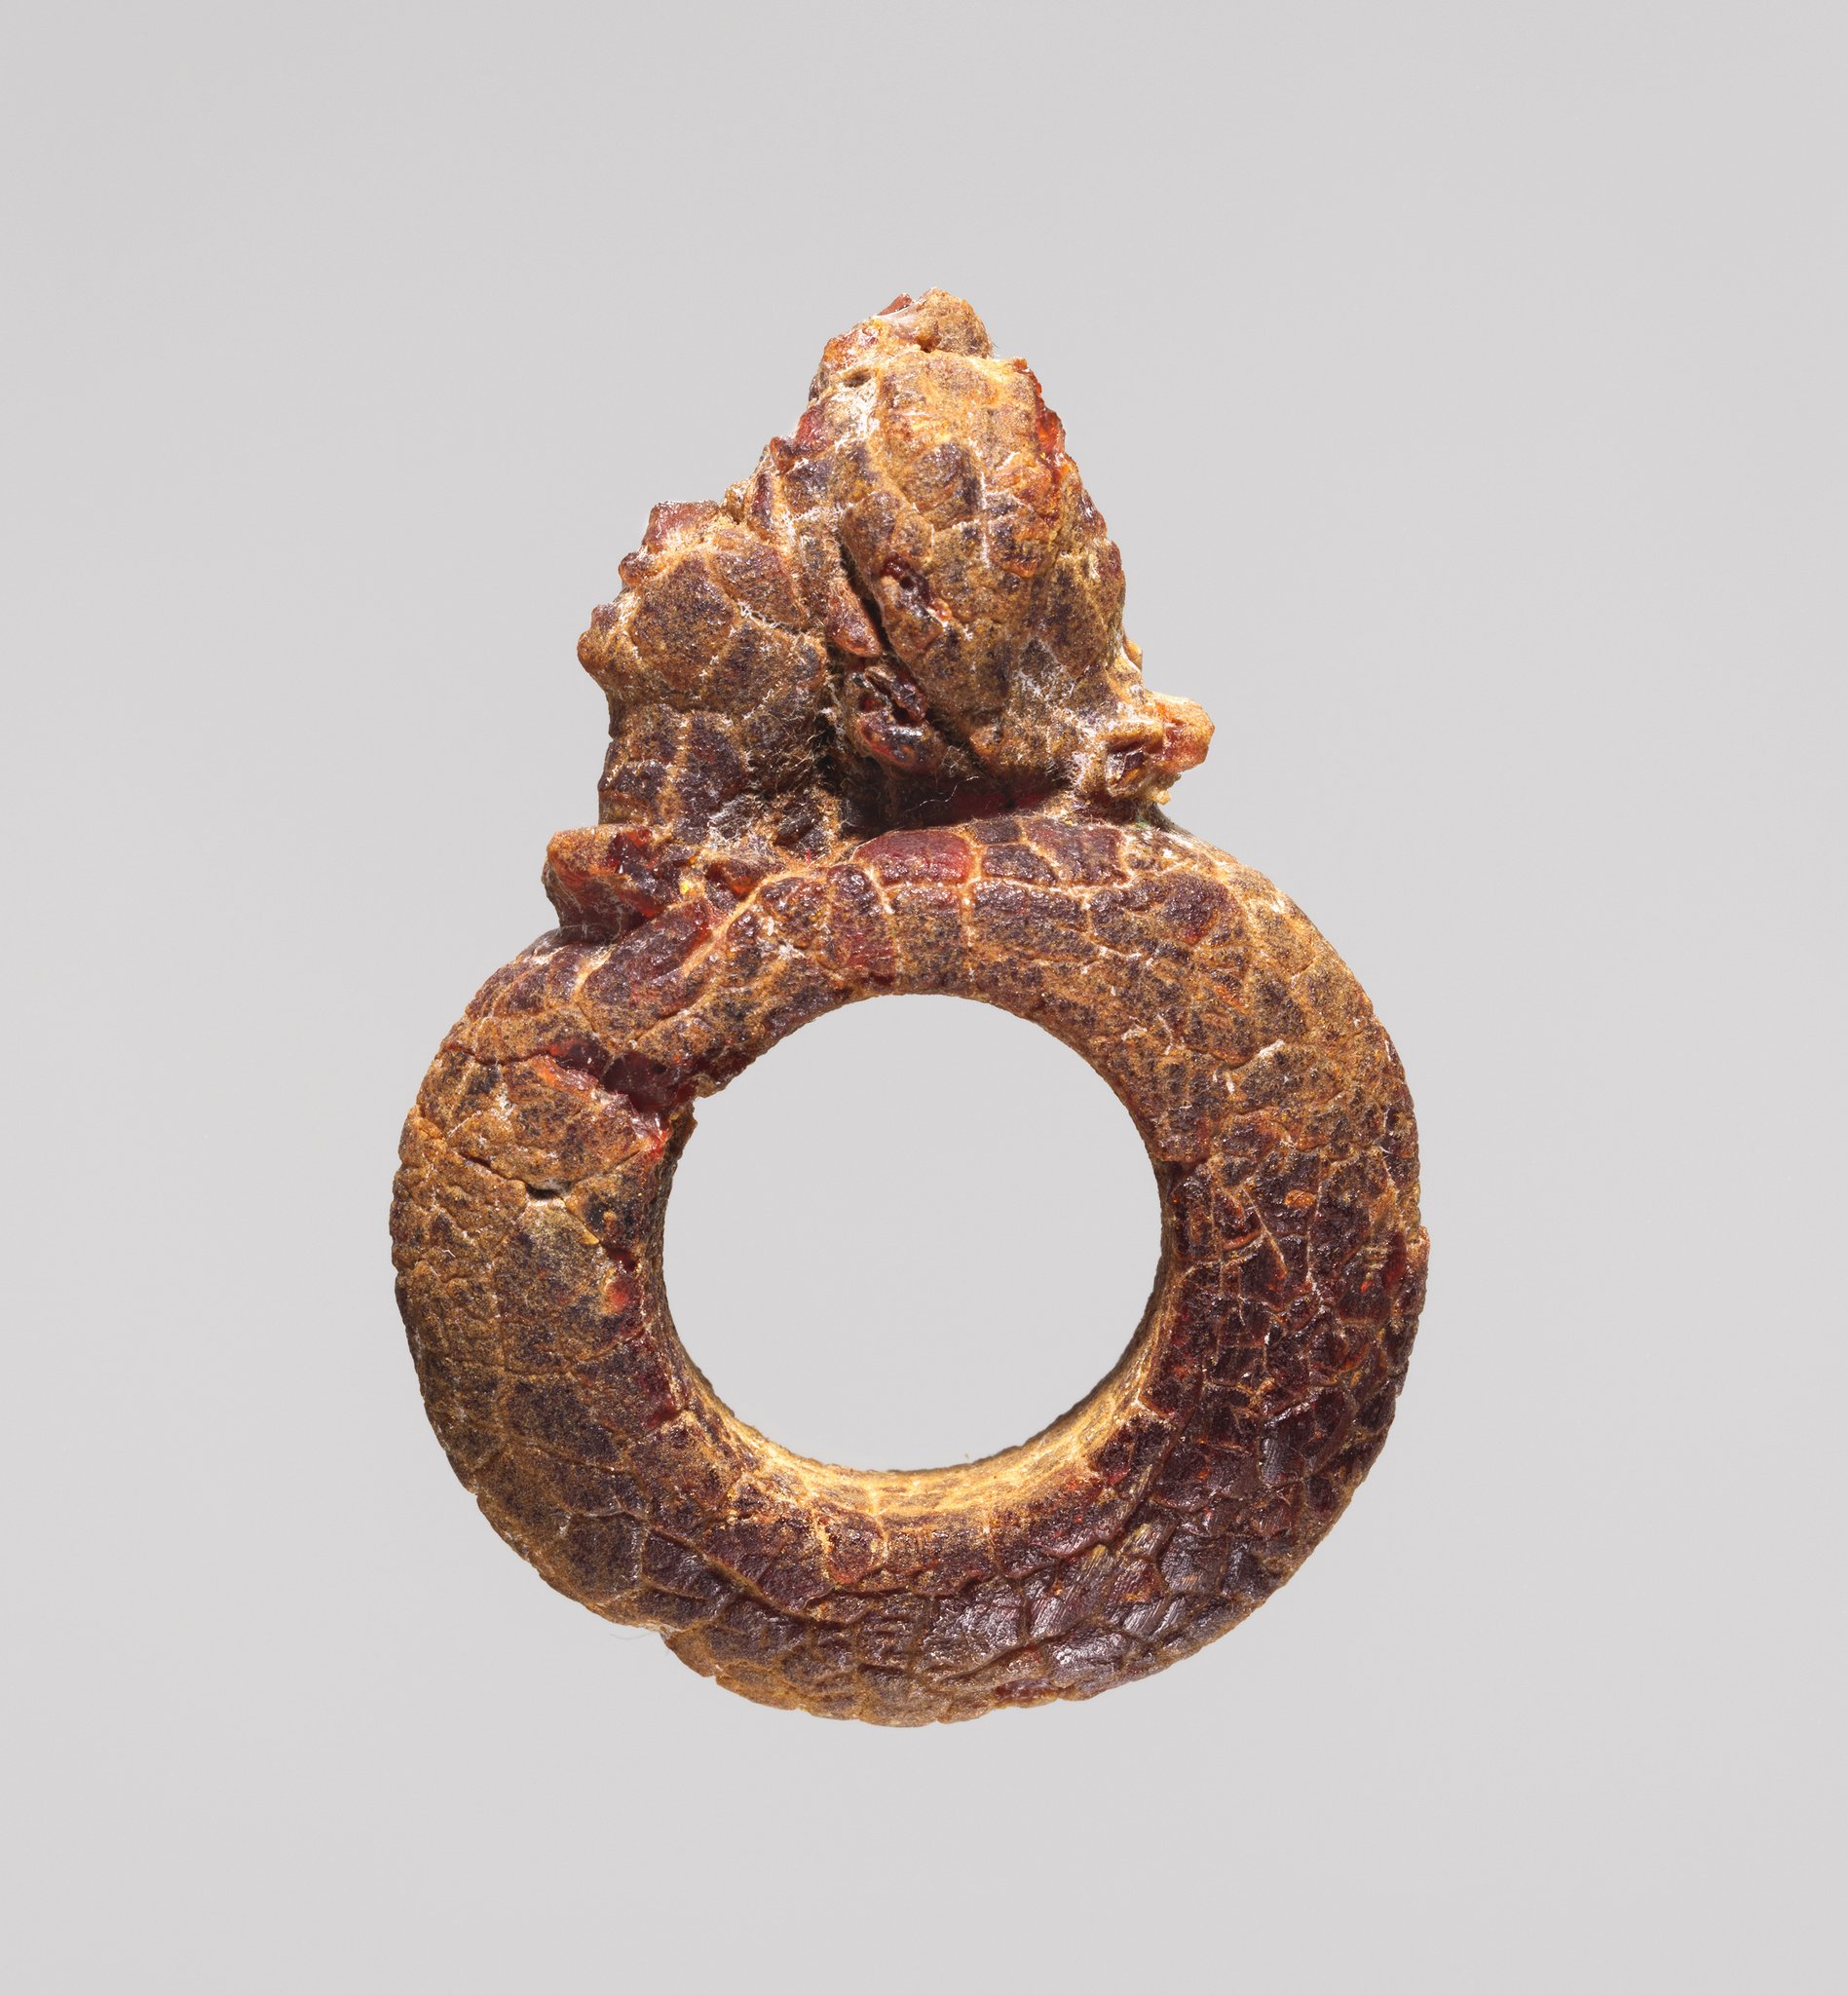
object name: ring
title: Amber ring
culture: roman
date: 67-166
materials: amber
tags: heads